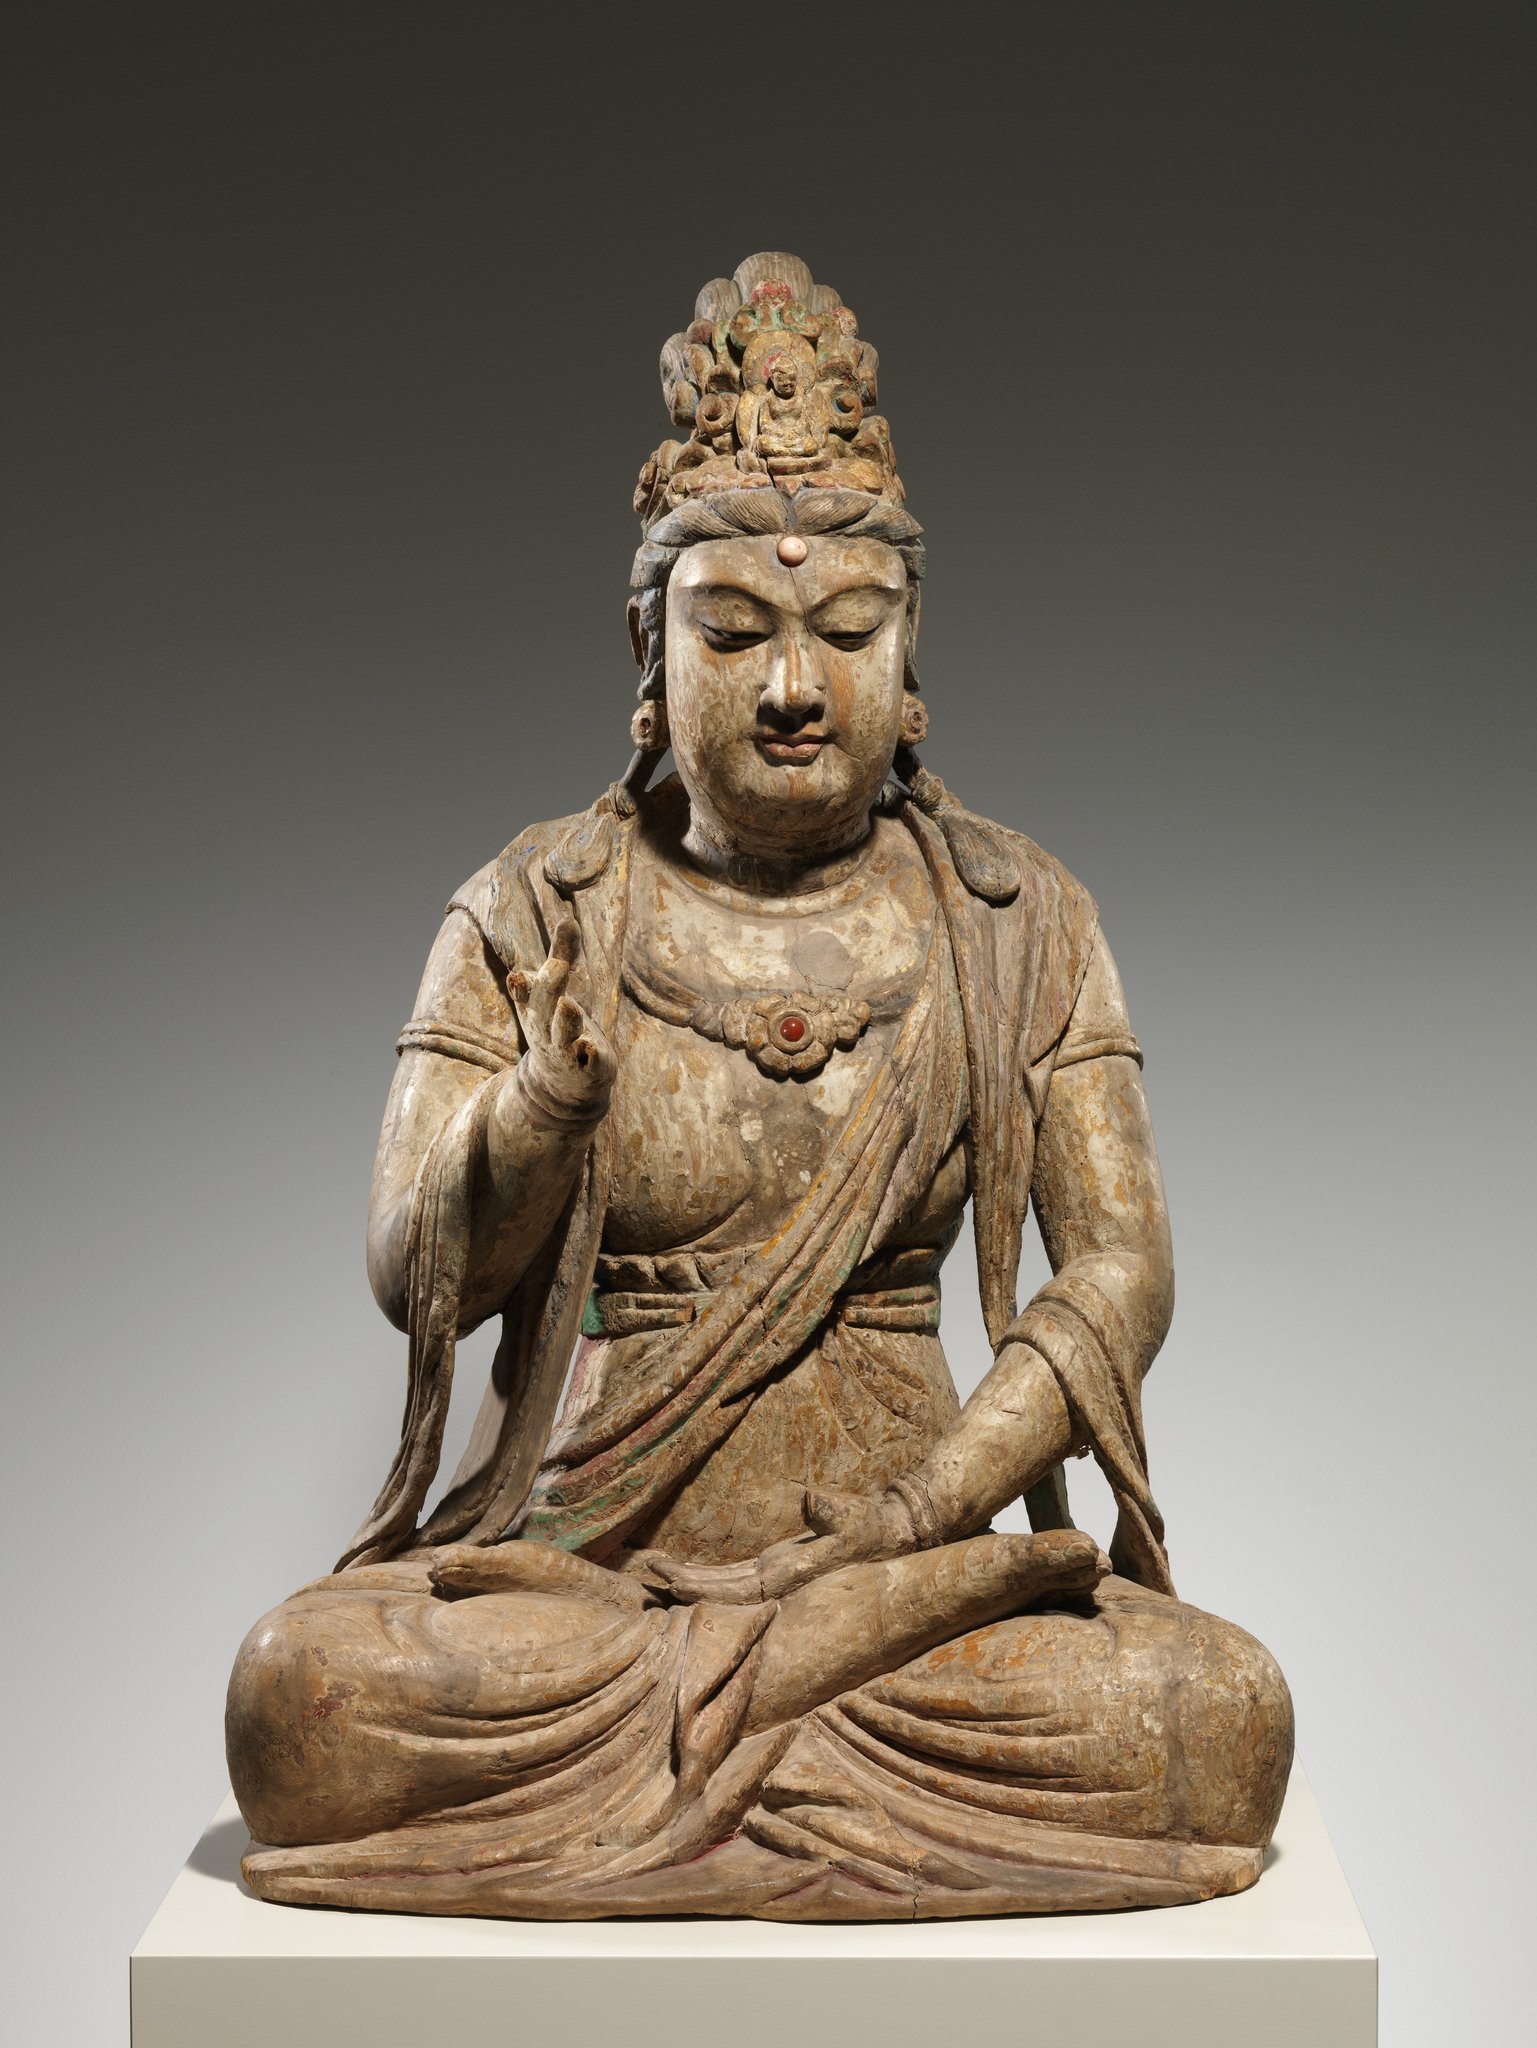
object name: figure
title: Bodhisattva Avalokiteshvara (Guanyin)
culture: chinese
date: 967-1033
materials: gemstone, pigment, quartz, wood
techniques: gilding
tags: buddhism,avalokiteshvara,bodhisattvas